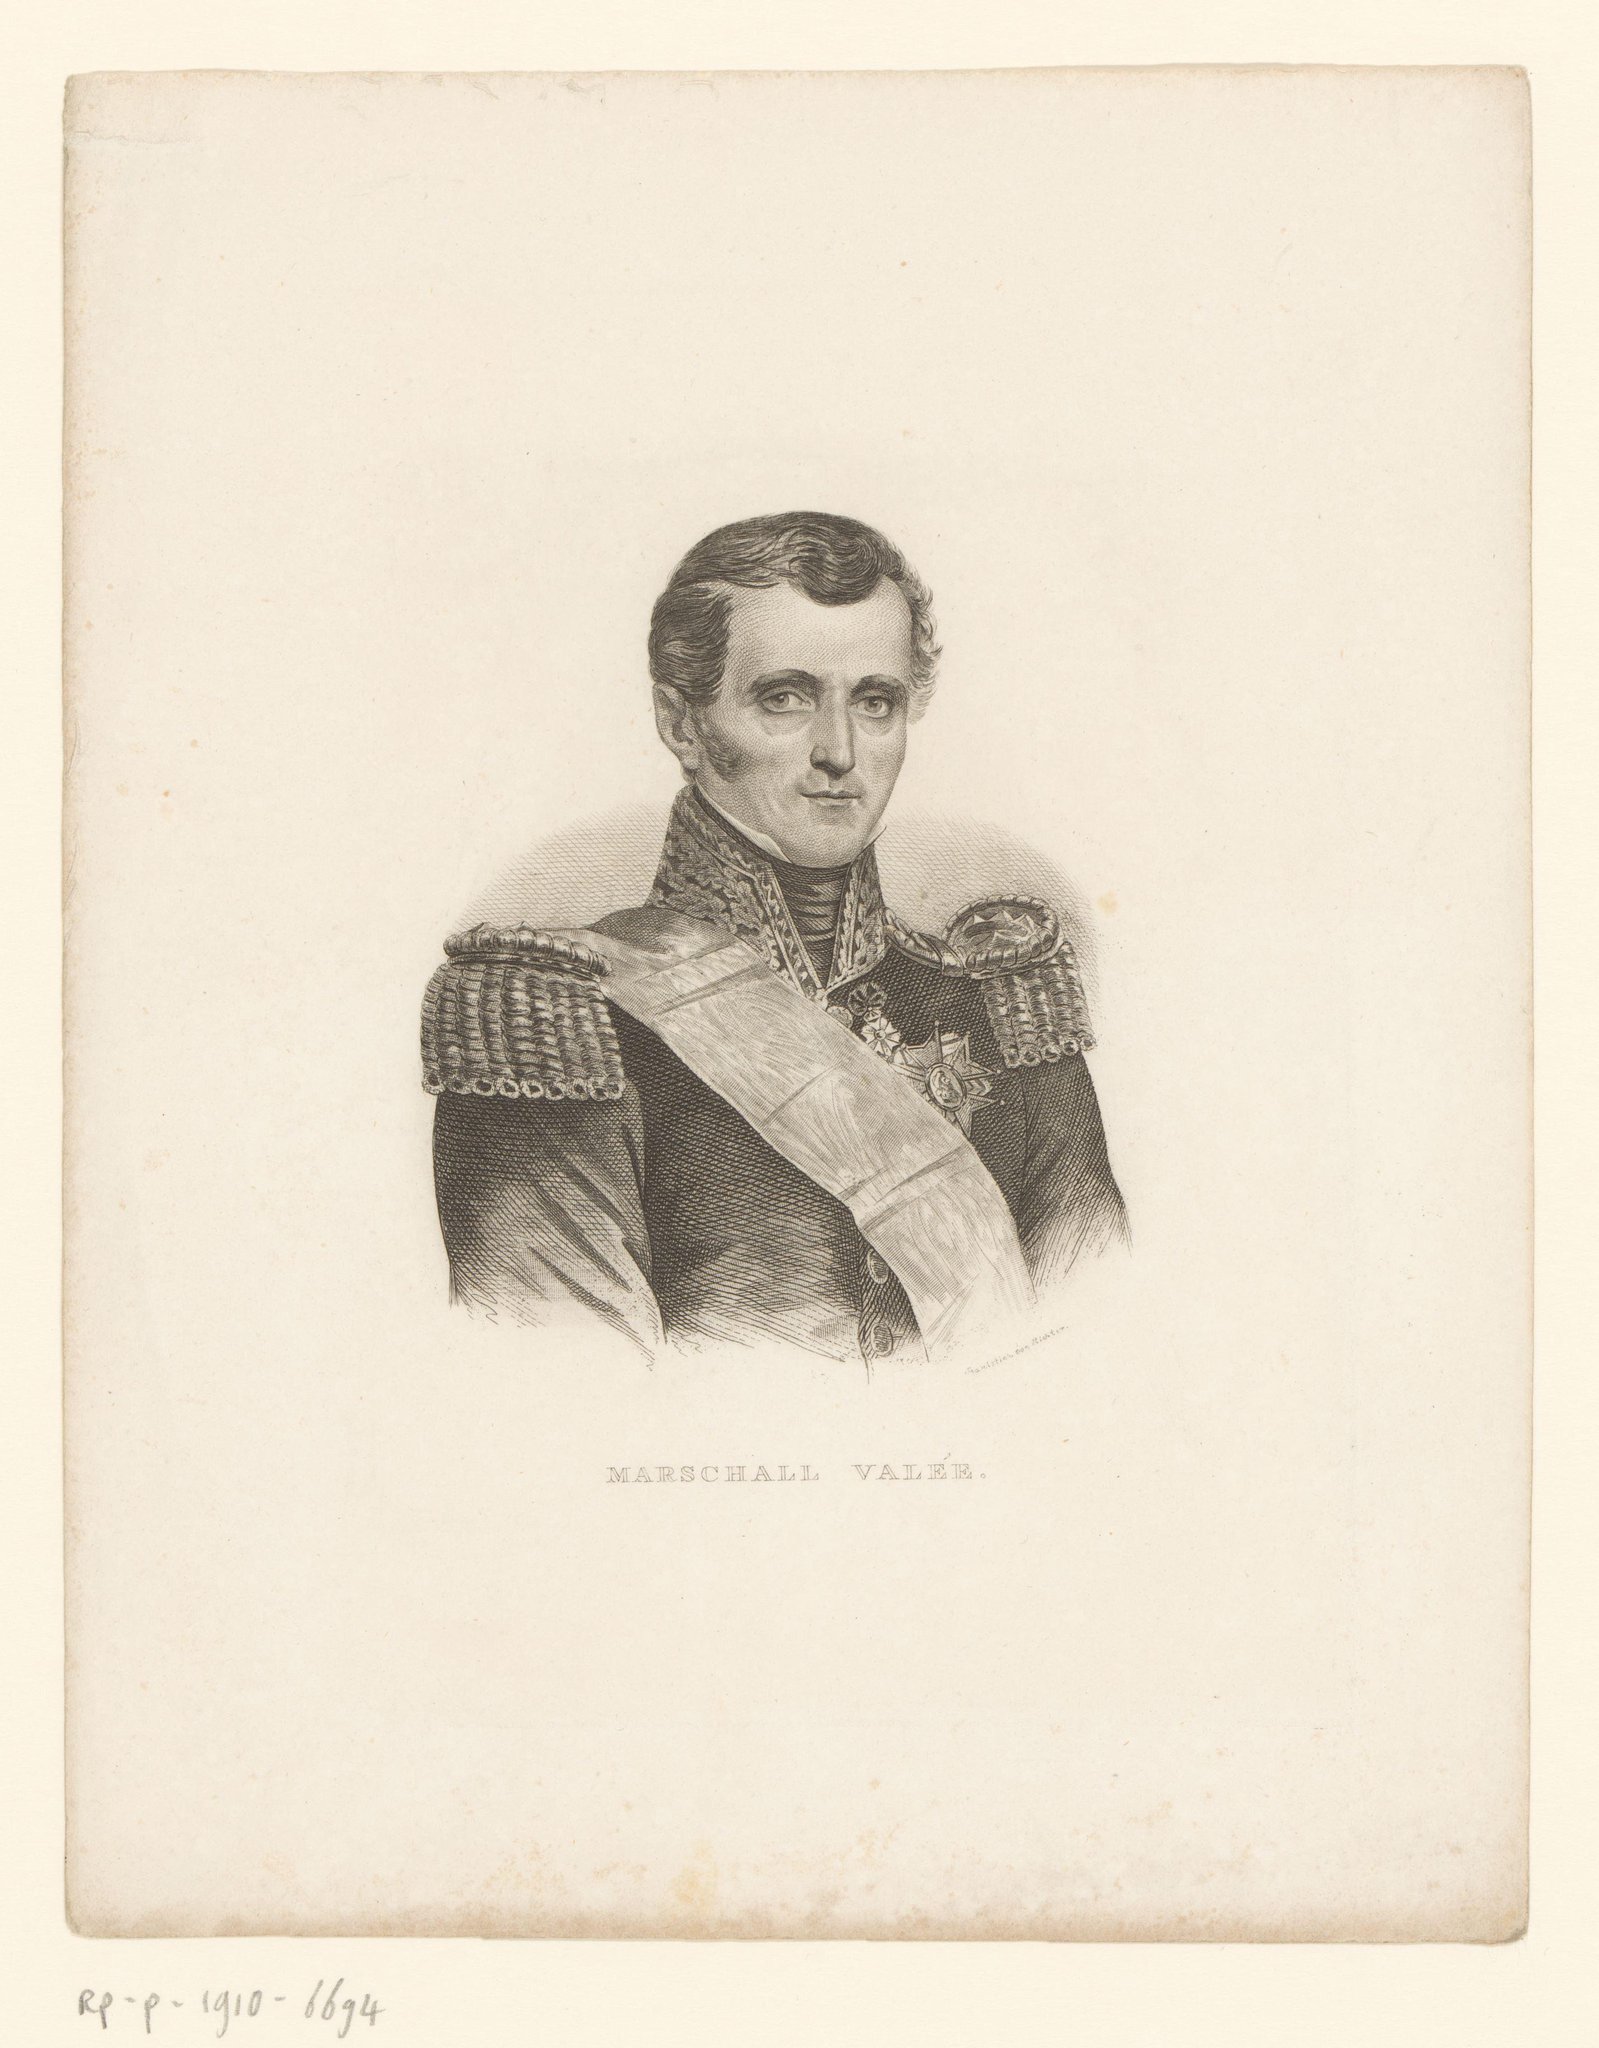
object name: print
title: Portret van Sylvain Charles Valée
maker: f. richter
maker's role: print maker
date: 1800-1899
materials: paper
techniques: roulette, engraving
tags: paris, historical persons, medals and other marks of military honour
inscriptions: collector's mark: Lugt 2228